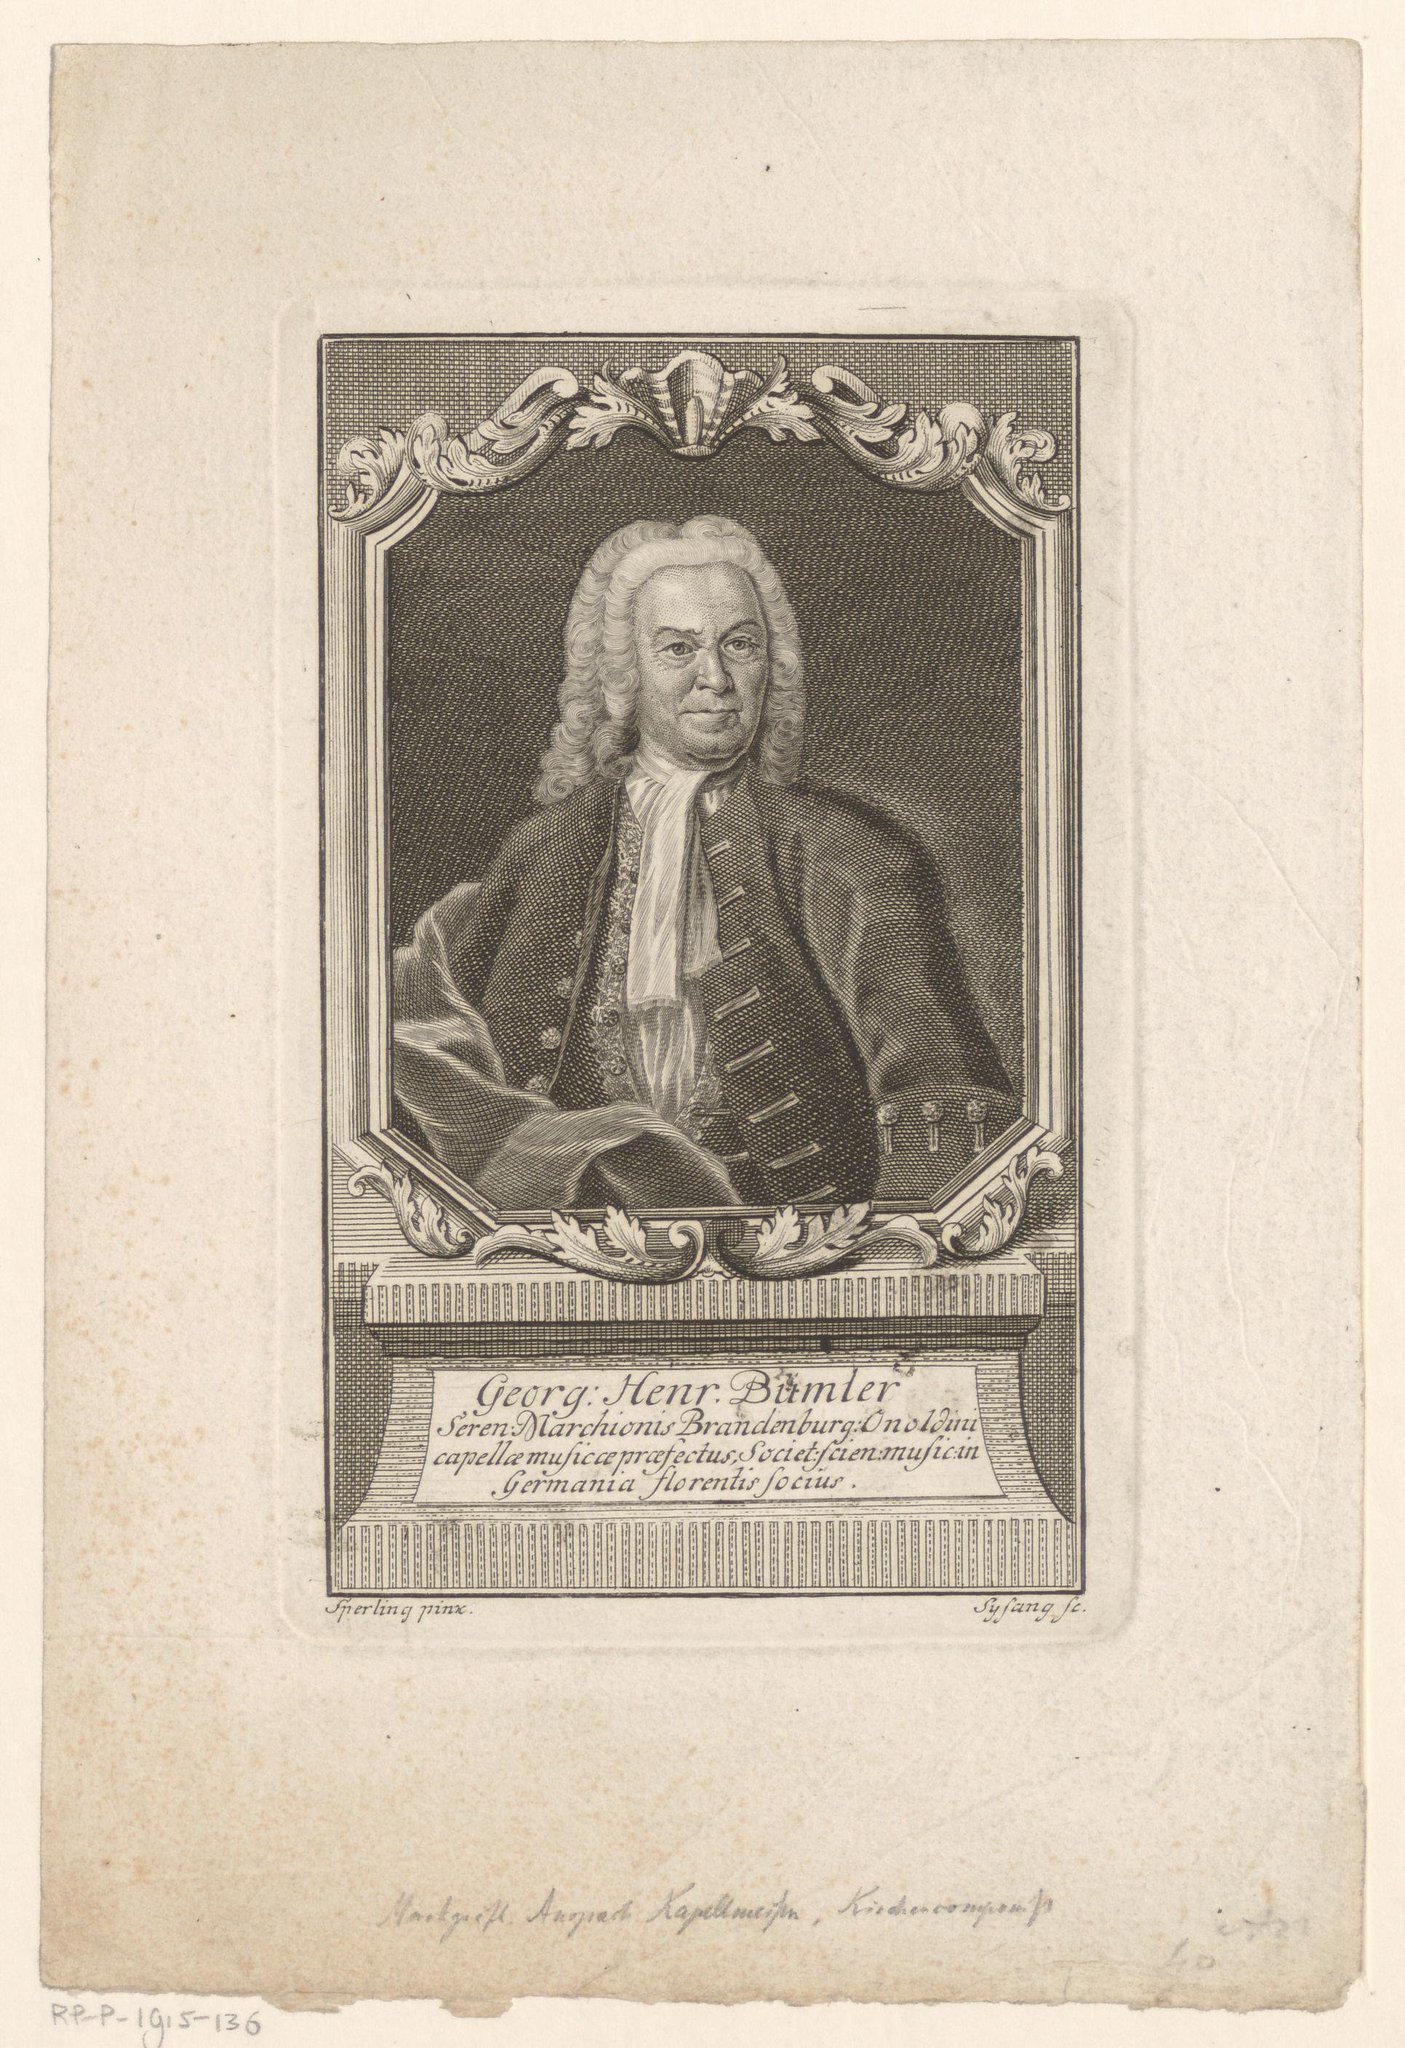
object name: print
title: Portret van Georg Heinrich Bümler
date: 1713-1757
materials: paper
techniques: engraving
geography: germany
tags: historical persons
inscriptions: collector's mark: Lugt 2228